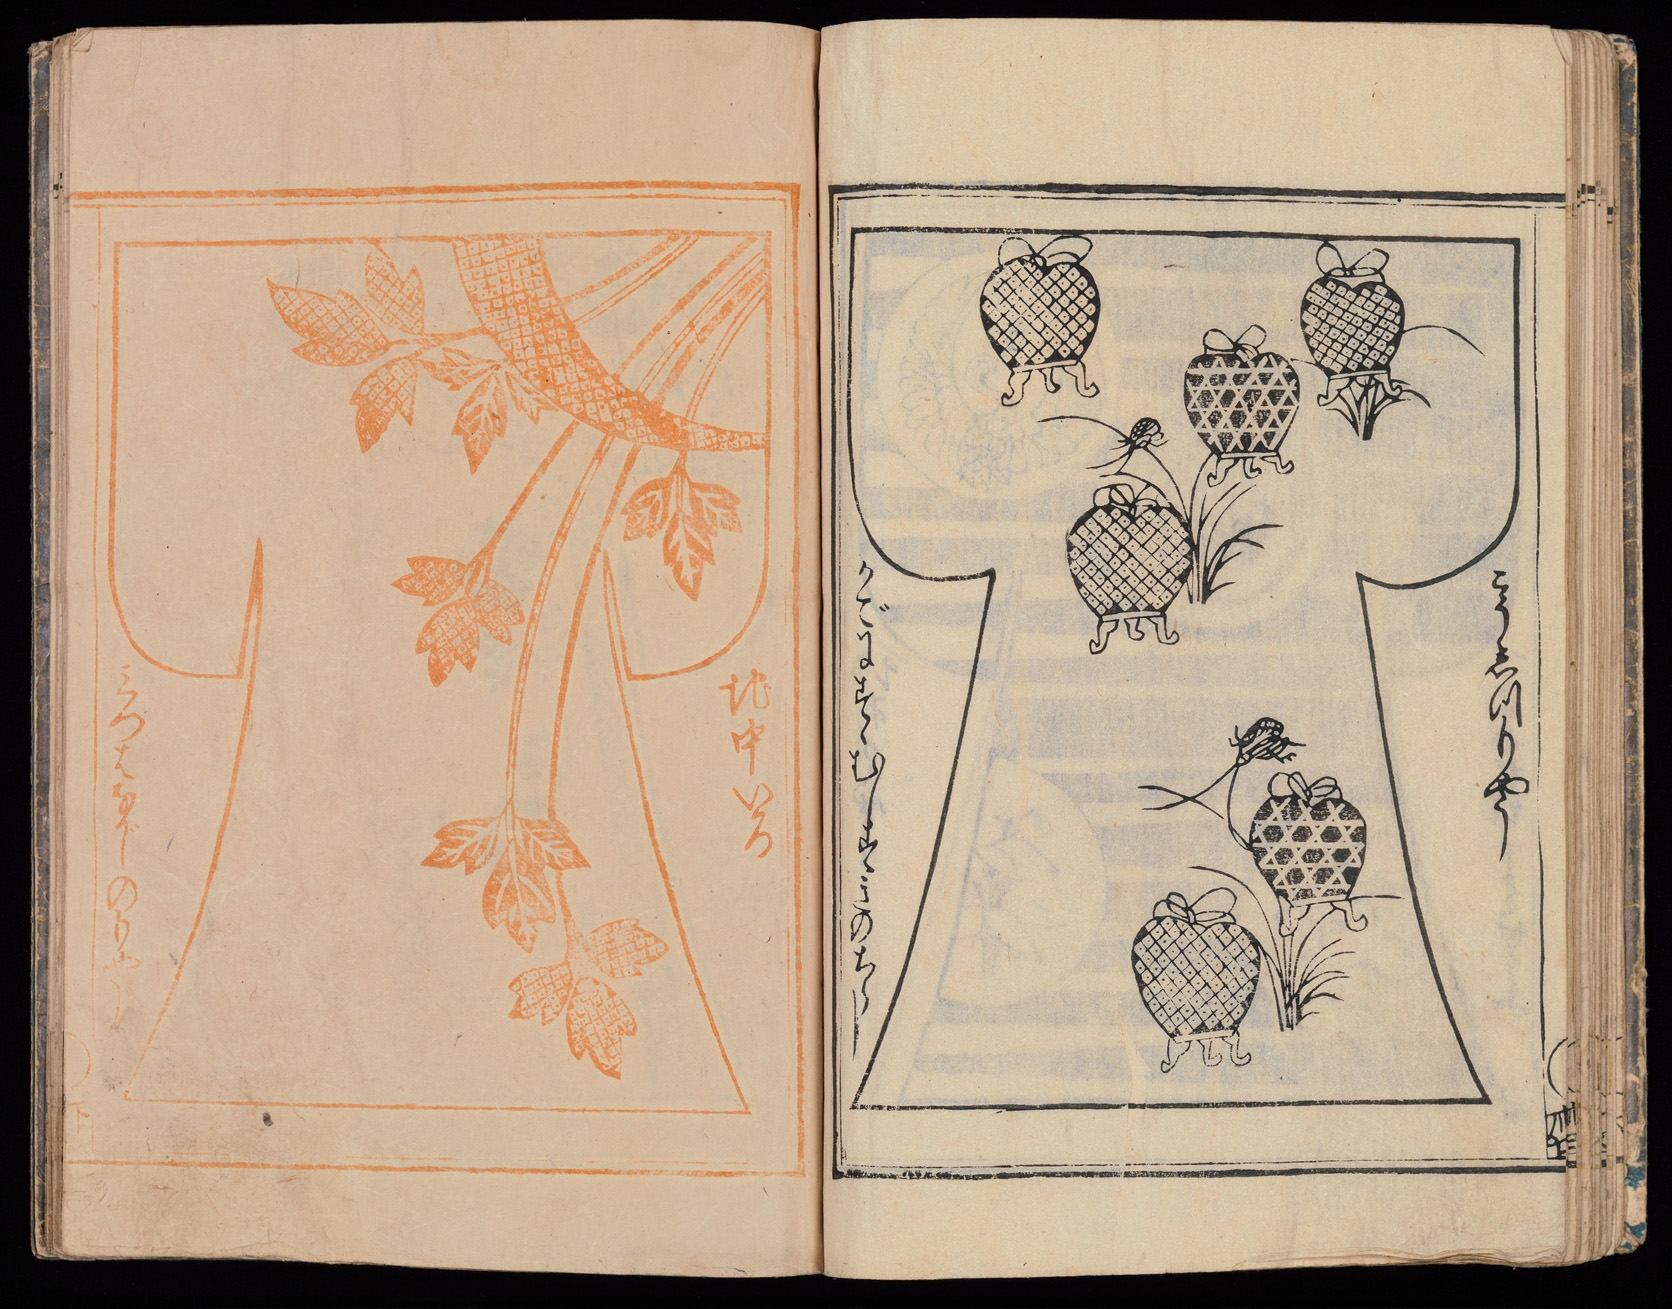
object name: illustrated book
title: Kosode Pattern Book (On-Hiinagata), vol. 2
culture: japanese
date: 1667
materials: ink, paper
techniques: woodblock print